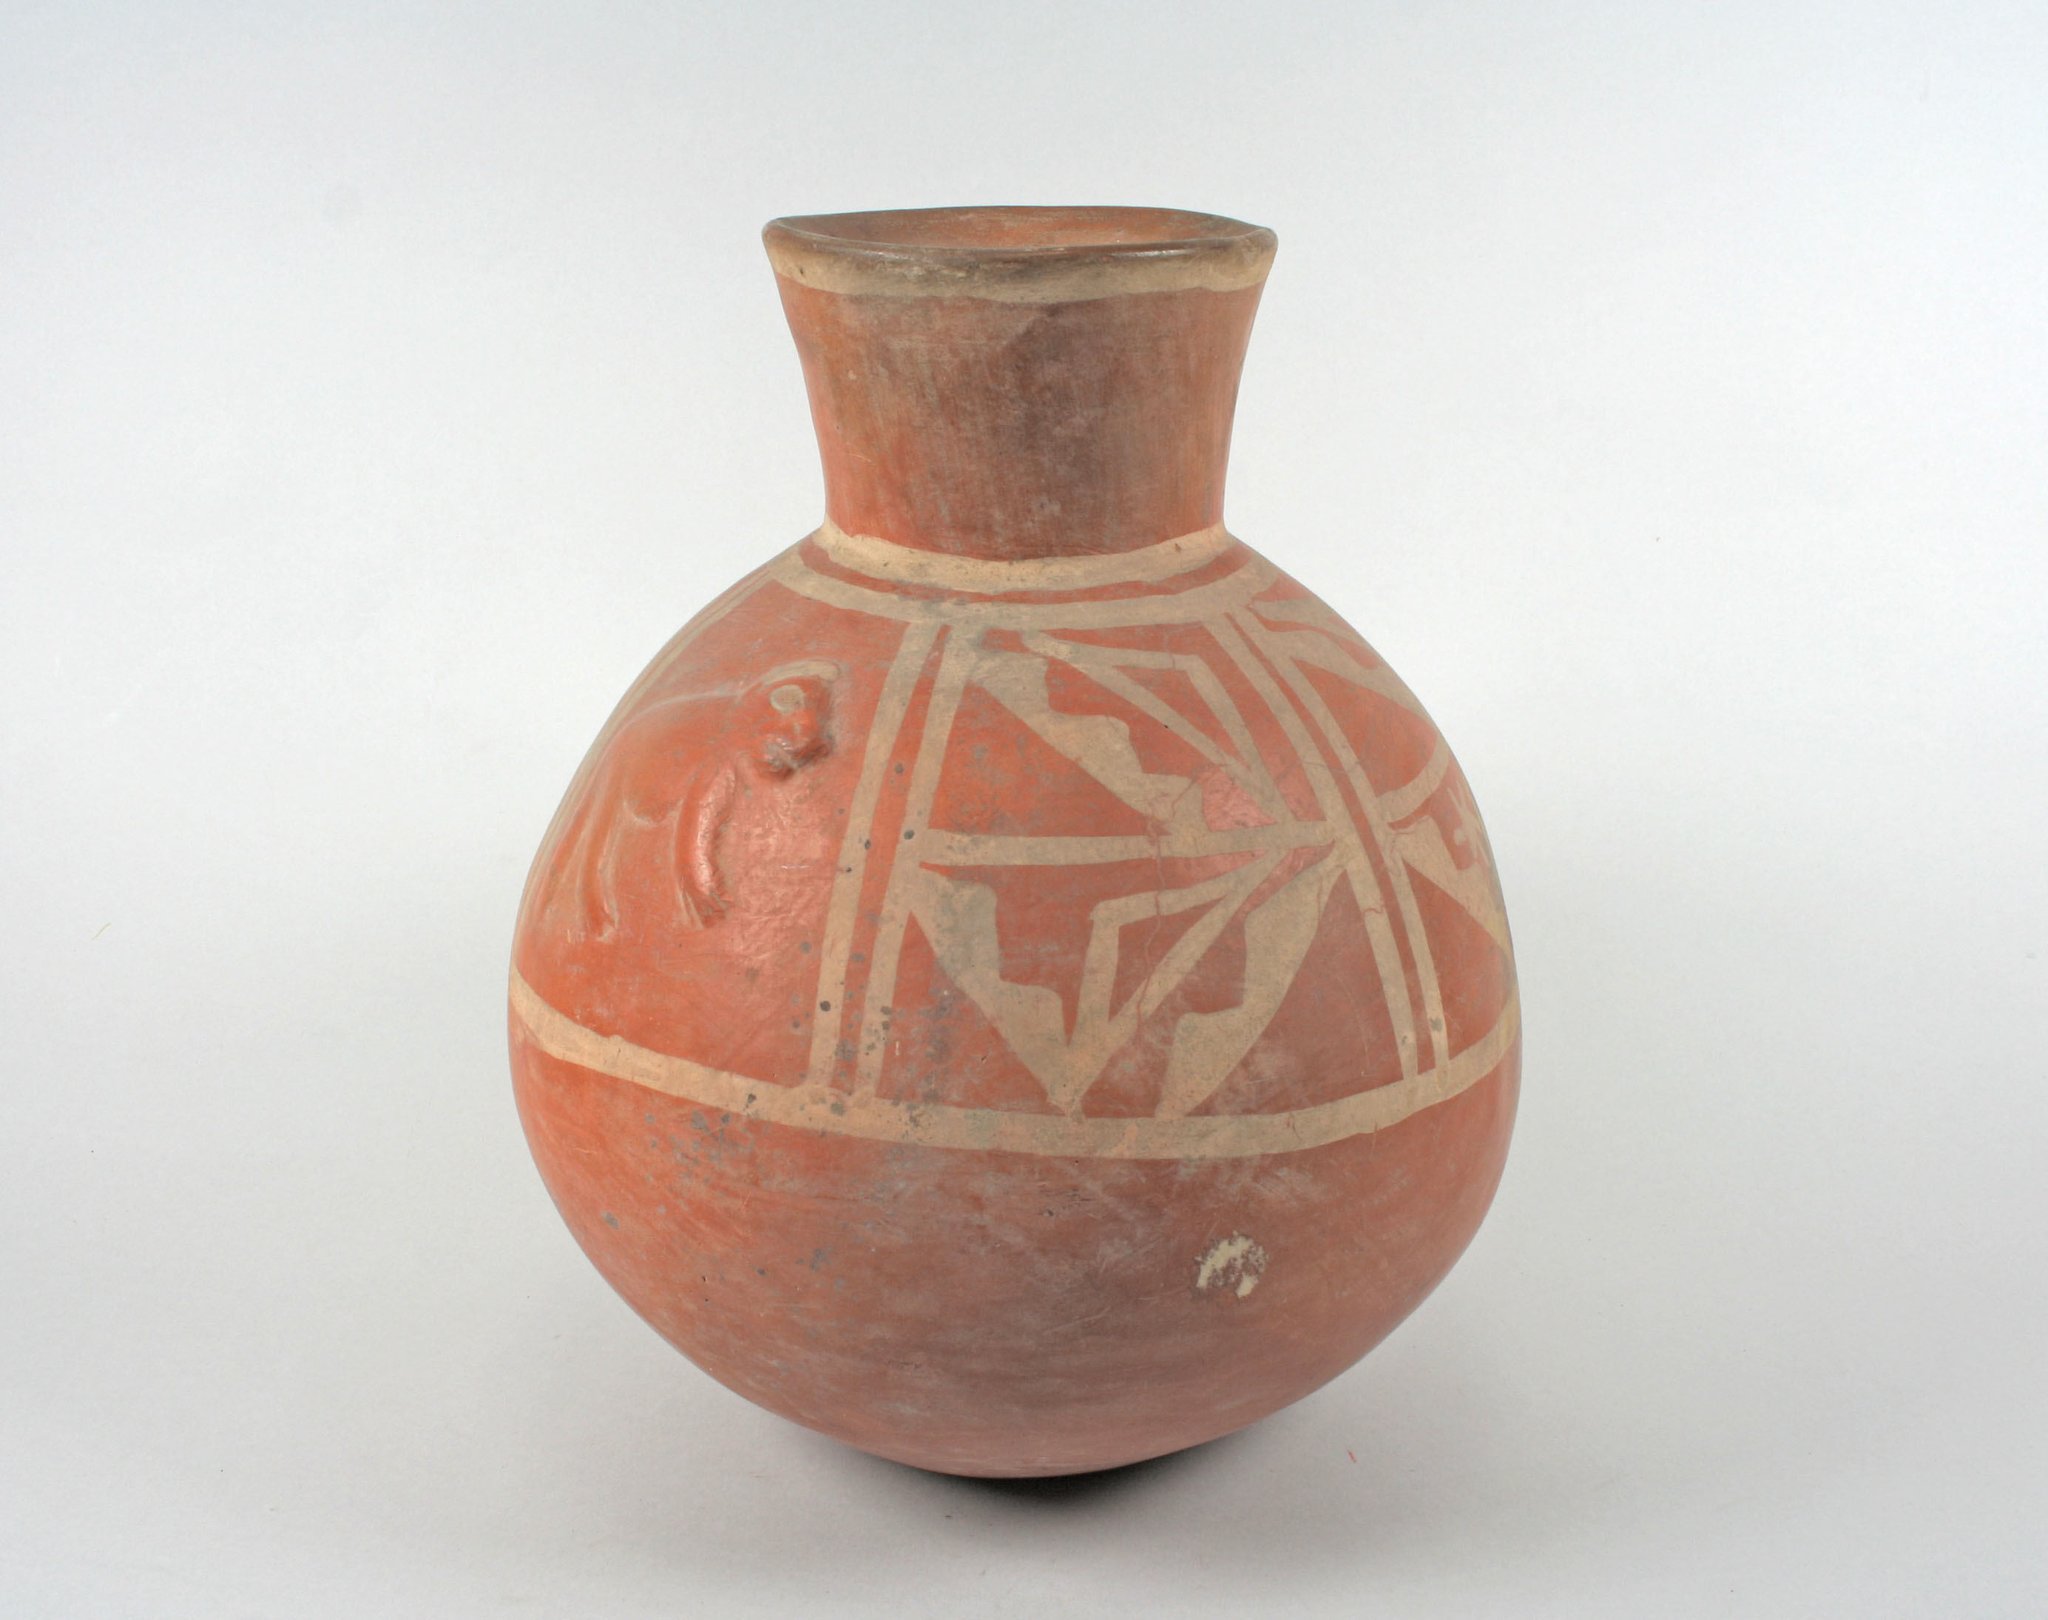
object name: bottle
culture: moche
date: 501-700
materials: ceramic, pigment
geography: peru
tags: animals